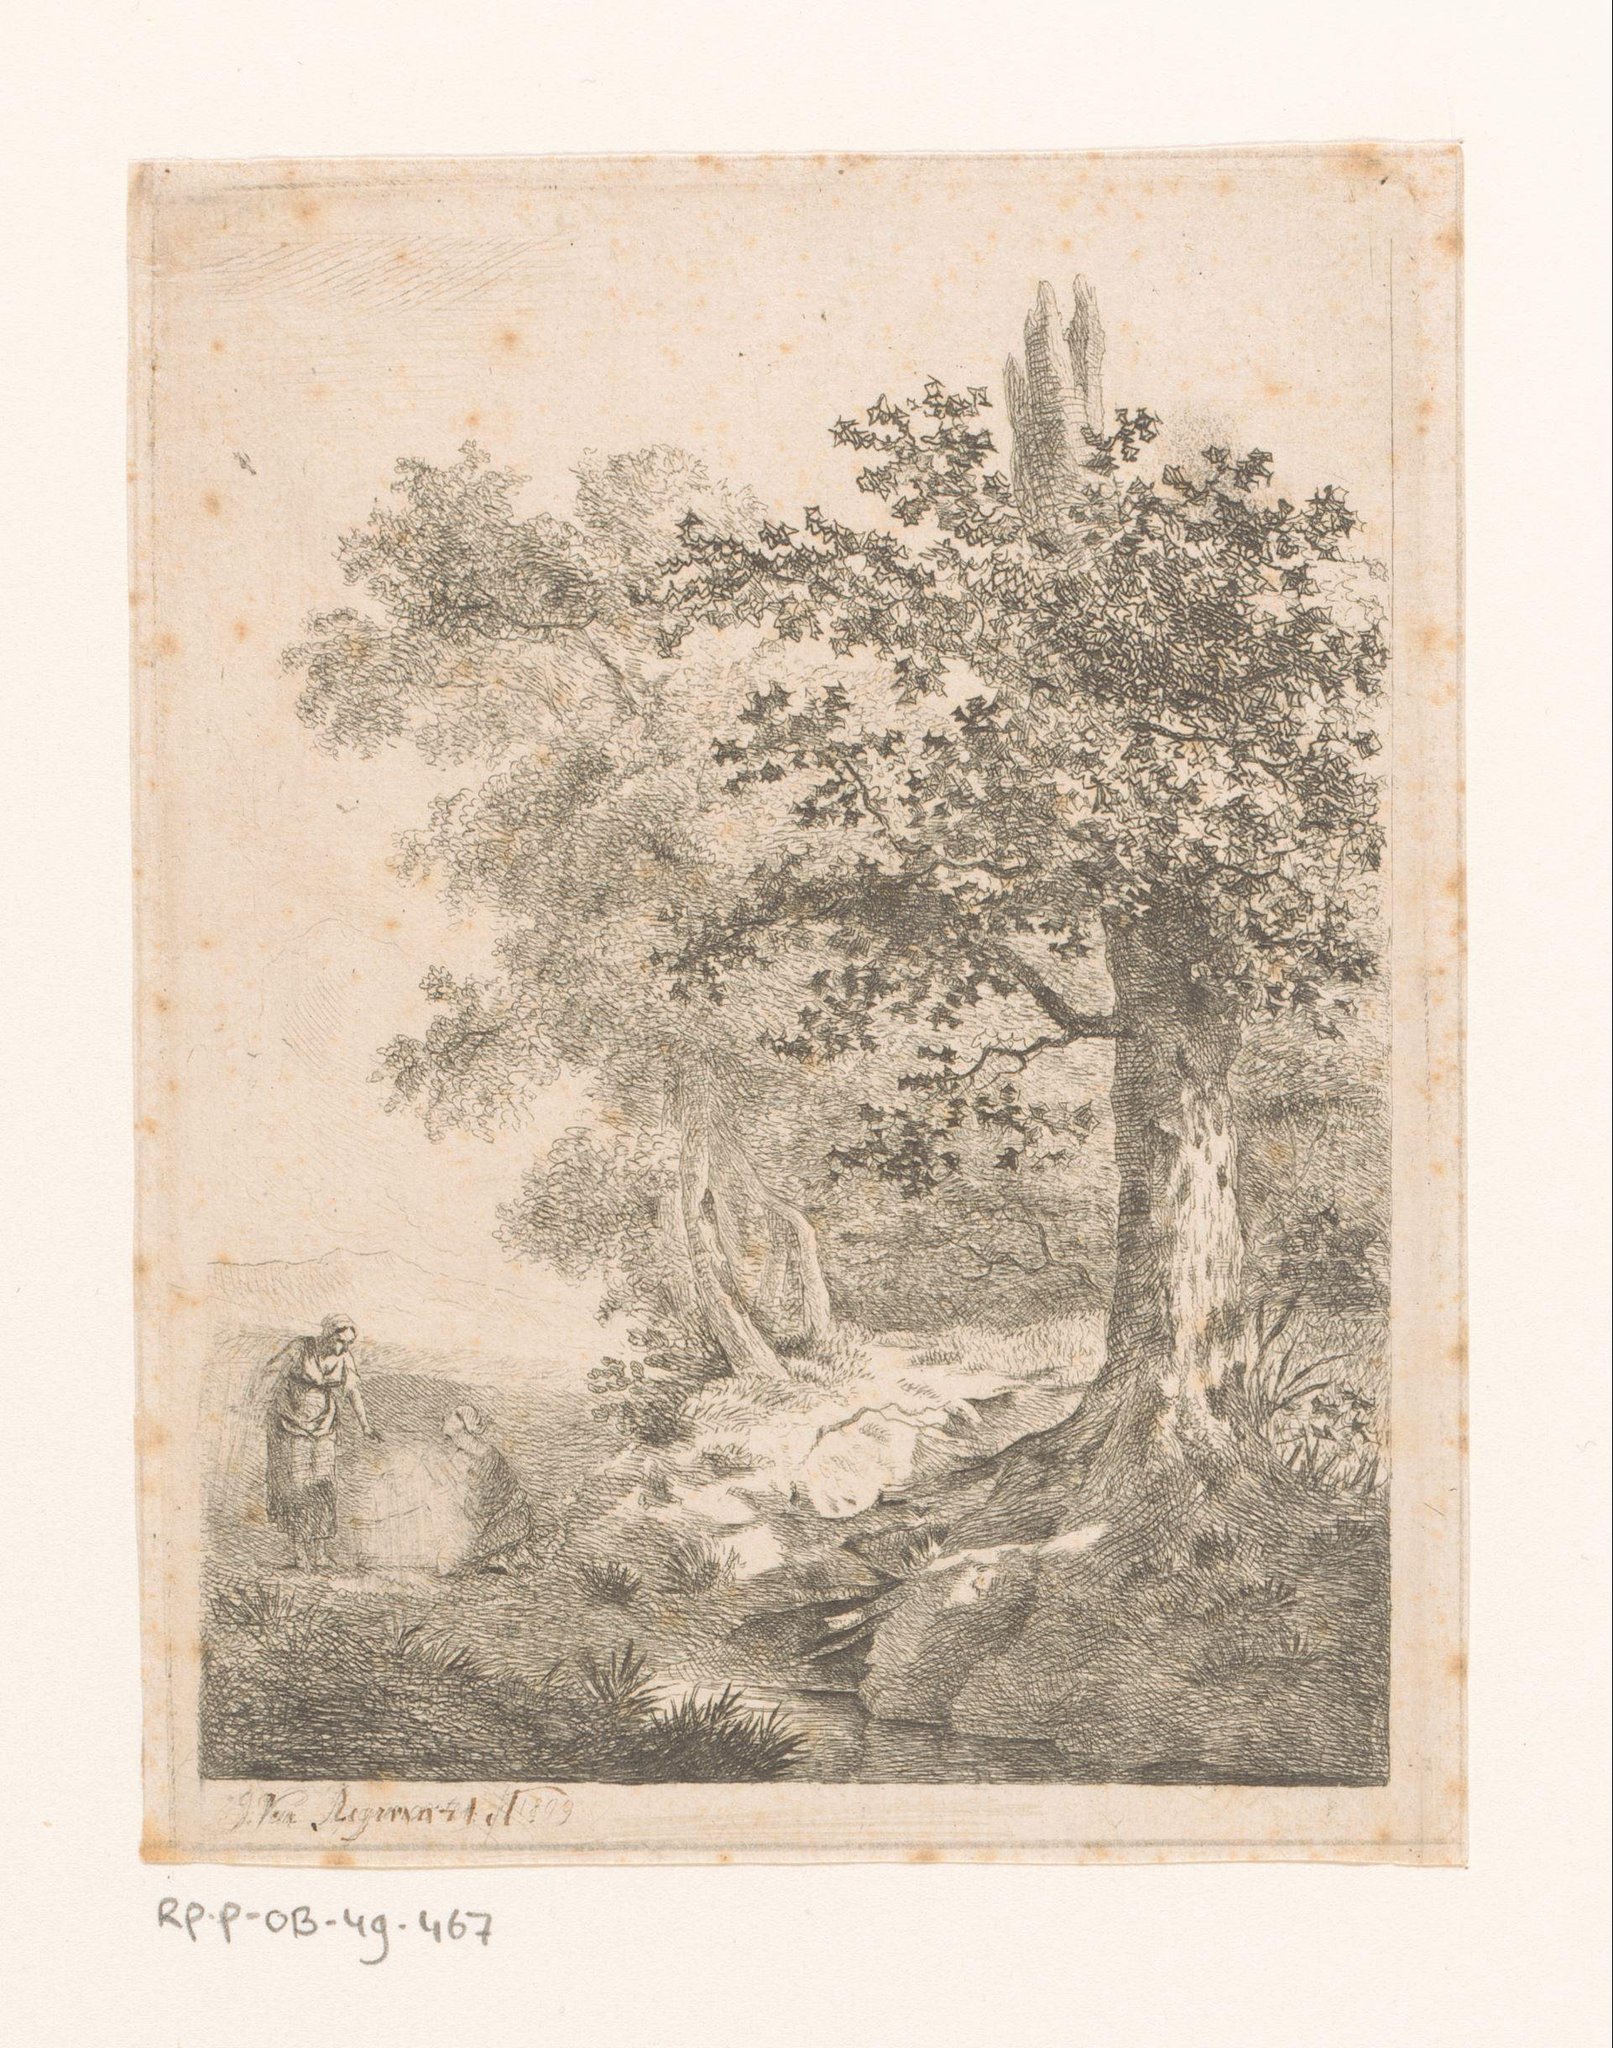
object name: print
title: Landschap met twee vrouwen bij een beek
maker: ignatius josephus van regemorter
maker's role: conservator, painter, print maker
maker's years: 1785-1873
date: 1809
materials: paper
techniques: etching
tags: adult woman, landscapes with waters, waterscapes, seascapes (in the temperate zone) (+ landscape with figures, staffage)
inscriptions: inscription: ‘J. van Regemorter 1809’